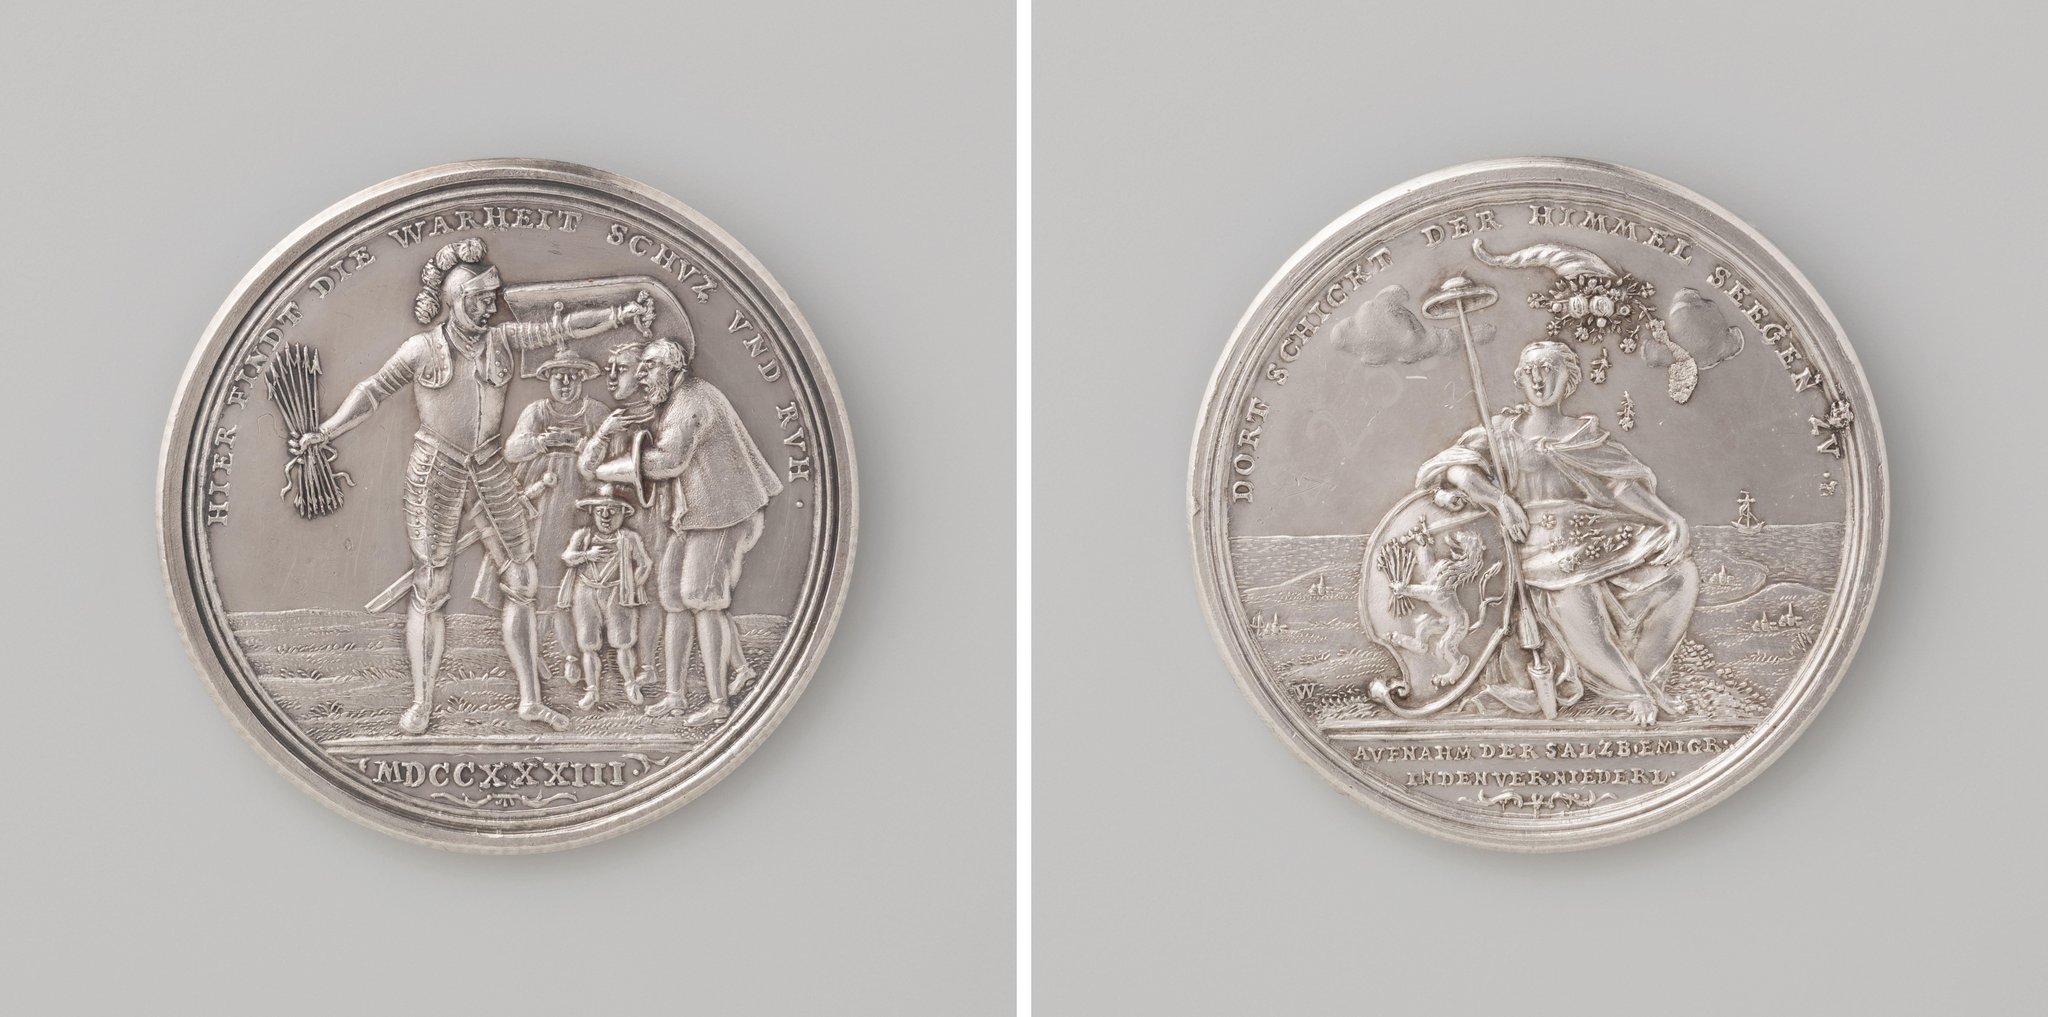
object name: history medal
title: Opname der Salzburger emigranten in Nederland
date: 1733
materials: silver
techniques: striking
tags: drievuldigheidskerk, breskens, opname der salzburger emigranten in nederland